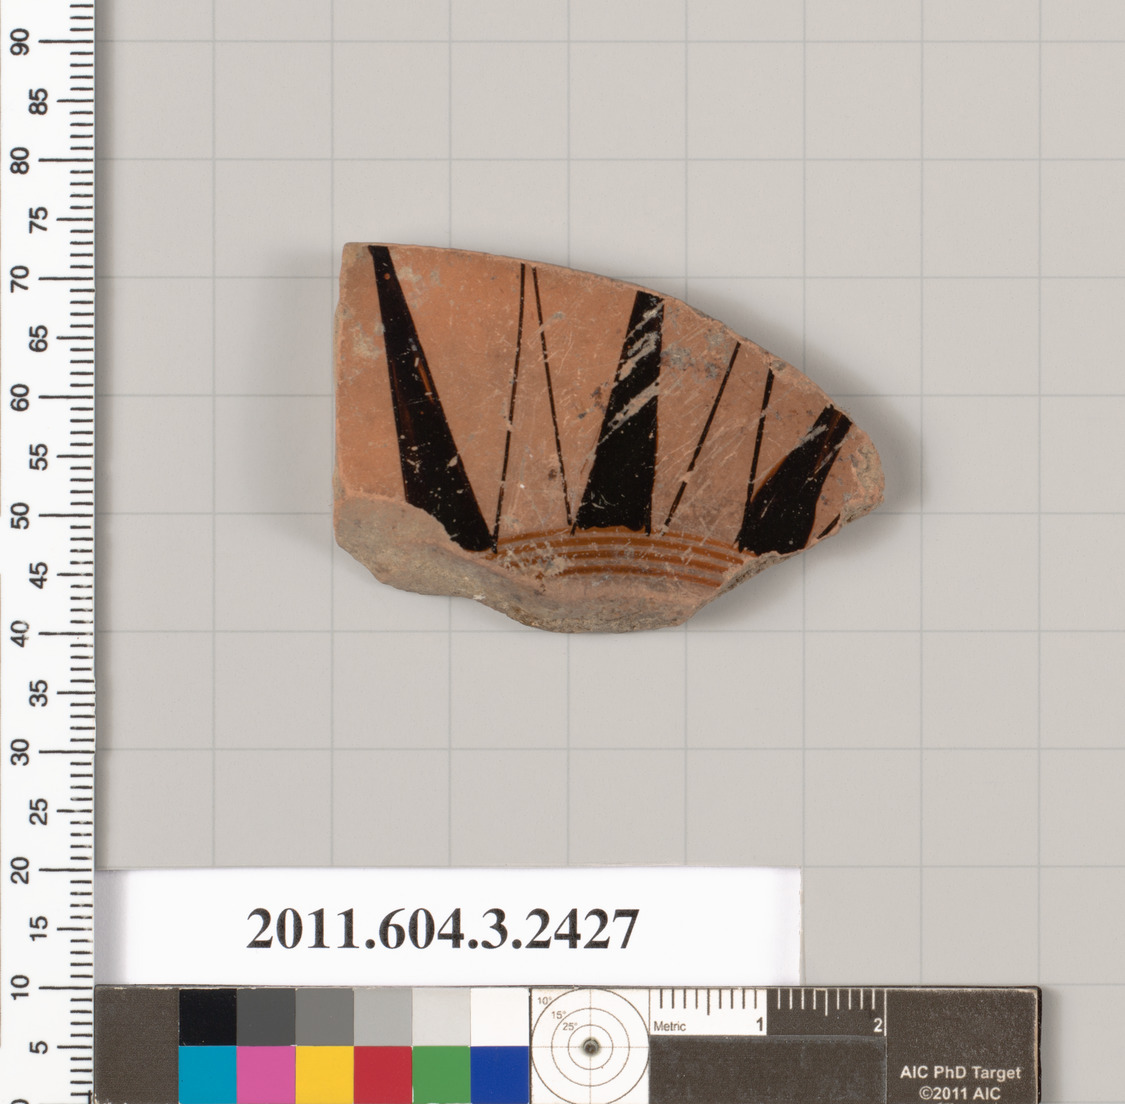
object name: kylix fragment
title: Terracotta fragment of a kylix: eye-cup (drinking cup)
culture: greek, attic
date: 530-520 BCE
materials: terracotta